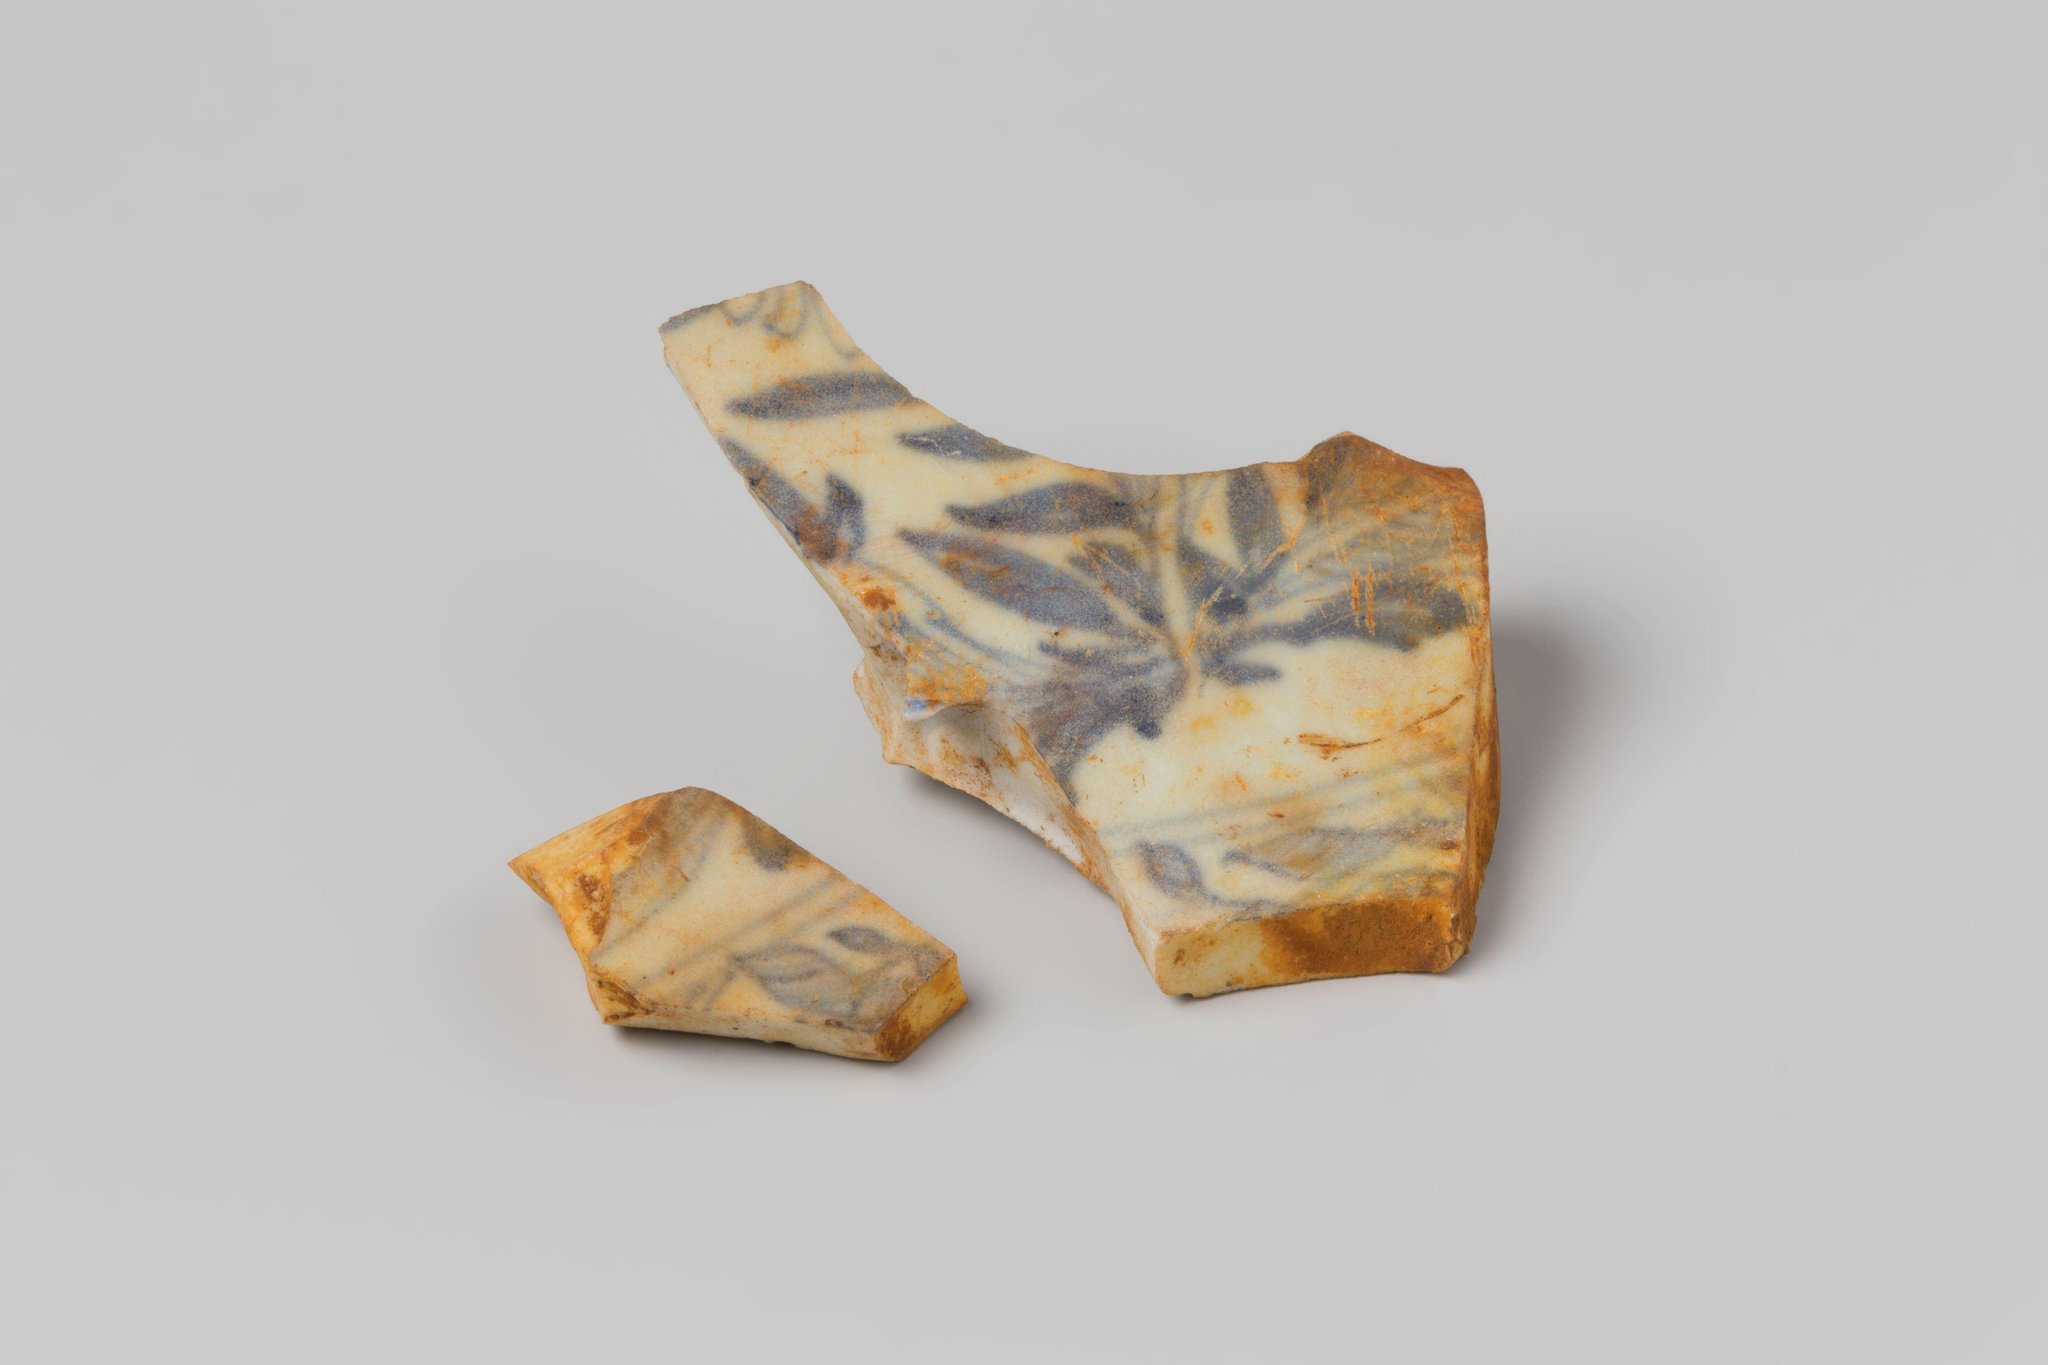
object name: sherd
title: Scherven van een bord uit het wrak van de Oost-Indiëvaarder Hollandia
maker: Anonymous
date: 1700-1743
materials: porcelain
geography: netherlands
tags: verenigde oostindische compagnie, hollandia (schip), annet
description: Porcelain, plate, type 2; fragm of base, sim. NG 1980-27H507.